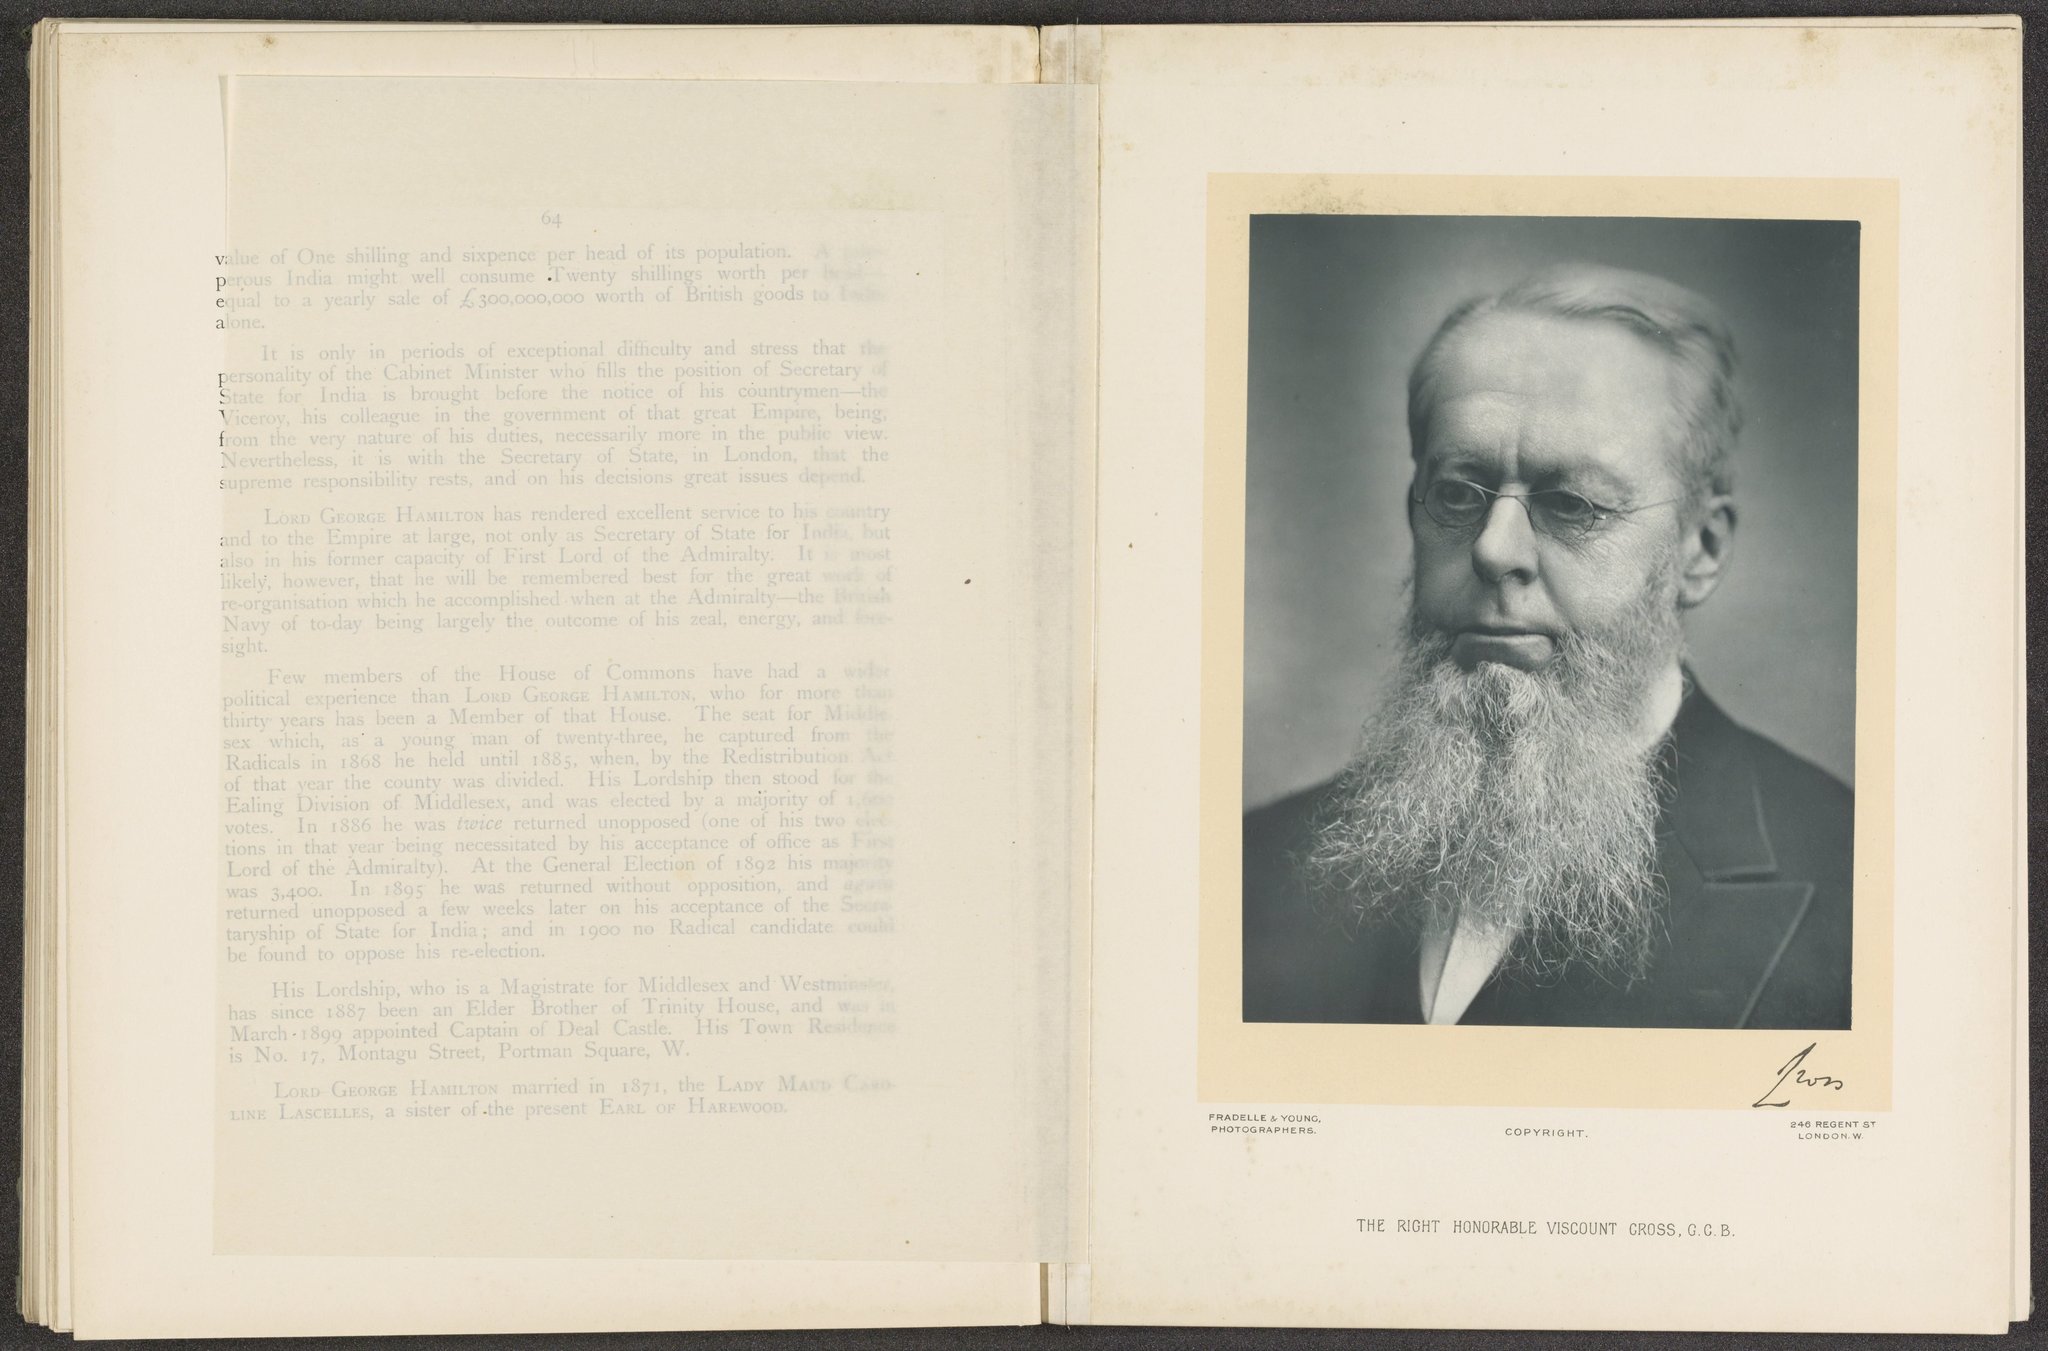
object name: page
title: The right honorable Viscount Cross, G.C.B.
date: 1893-1903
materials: paper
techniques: carbon print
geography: london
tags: historical persons (portraits and scenes from the life) (+ (full) bust portrait)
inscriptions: inscription: ‘246 Regent St London, W.’, annotation